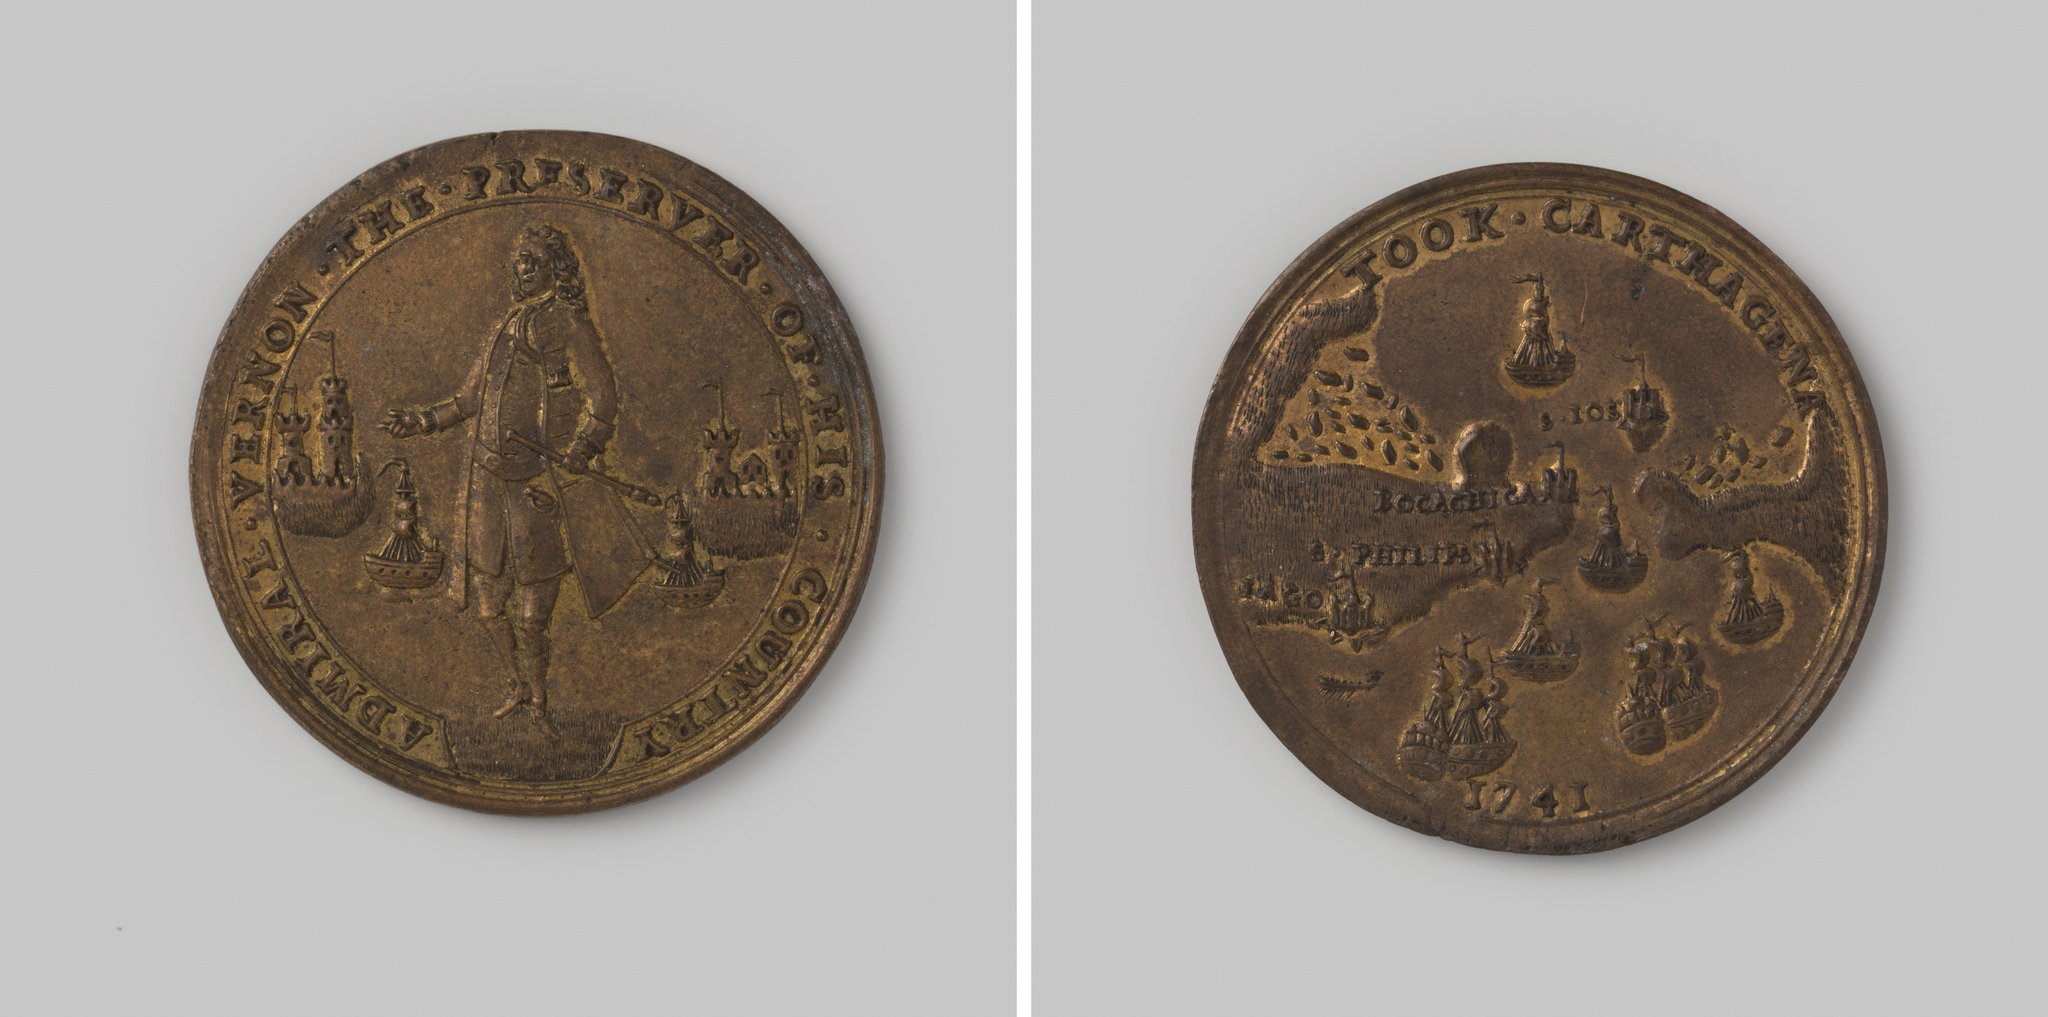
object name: history medal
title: Inname van Carthagena door Admiraal Vernon 1741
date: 1741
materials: brass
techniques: striking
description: Verguld messing penning, op de voorzijde Vernon staand naar links, achter hem twee schepen en twee kastelen, met omschrift, op de keerzijde de landengte van Cartagena in vogelvlucht met schepen en kastelen, met omschrift.